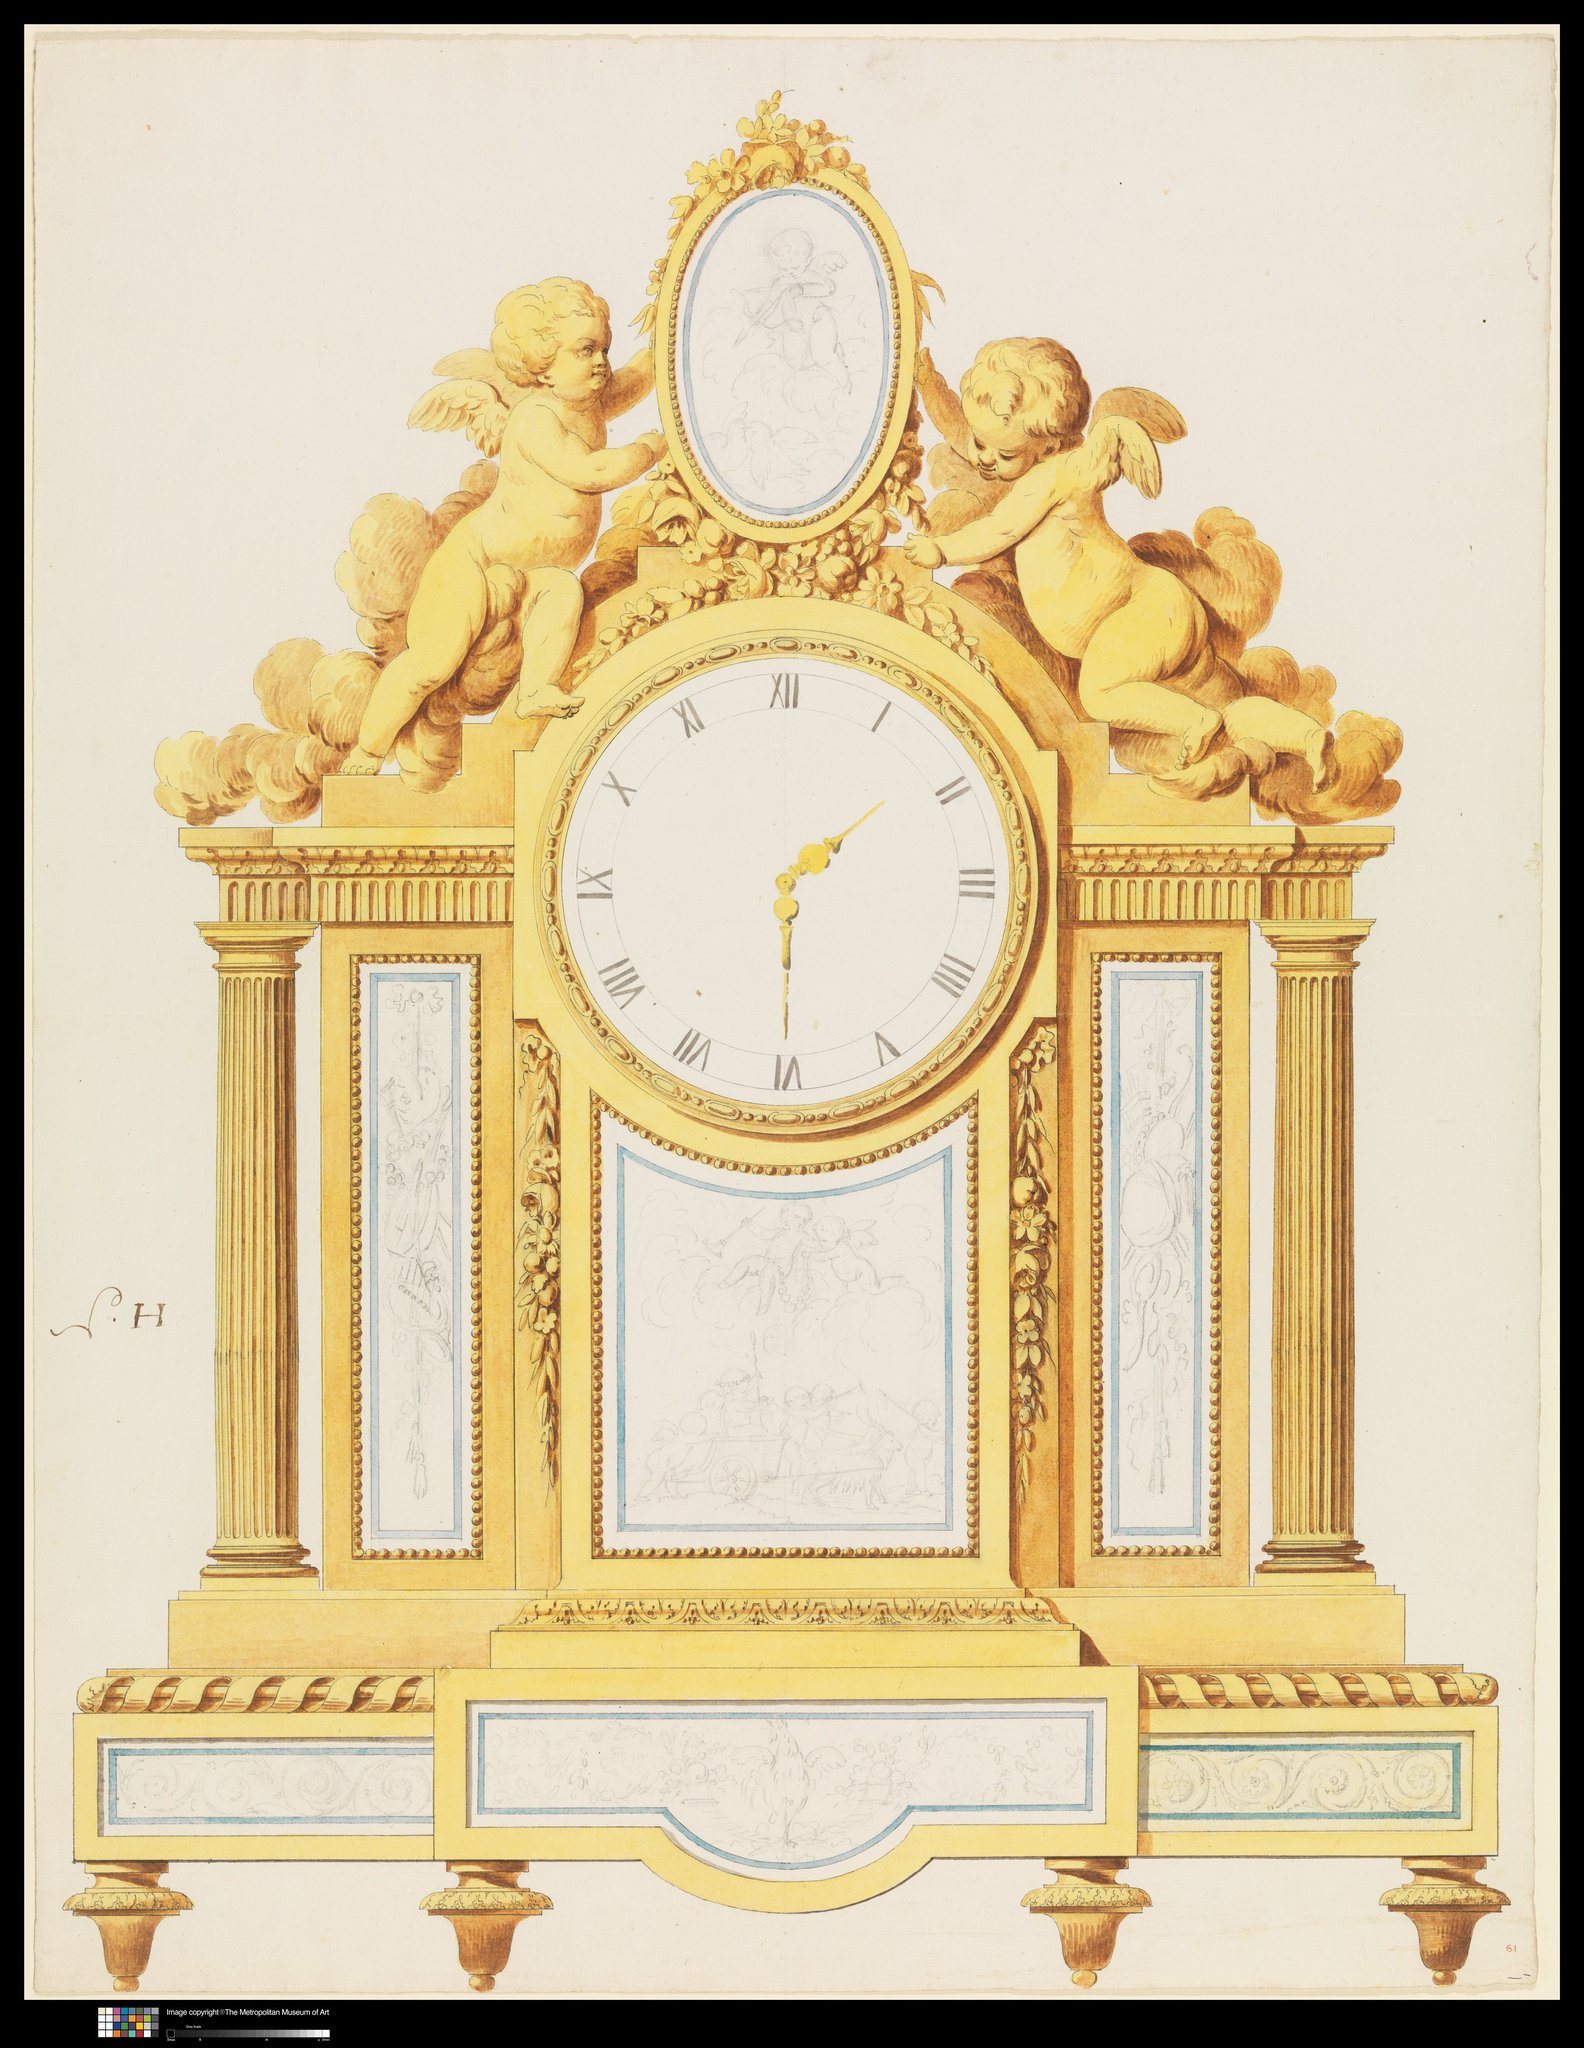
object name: drawing ornament architecture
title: Design for a Neoclassical Clock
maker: anonymous, french, 18th century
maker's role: artist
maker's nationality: french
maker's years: 1700-1800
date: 1770-1785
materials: graphite, ink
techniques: brush, pen, wash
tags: putti,clocks